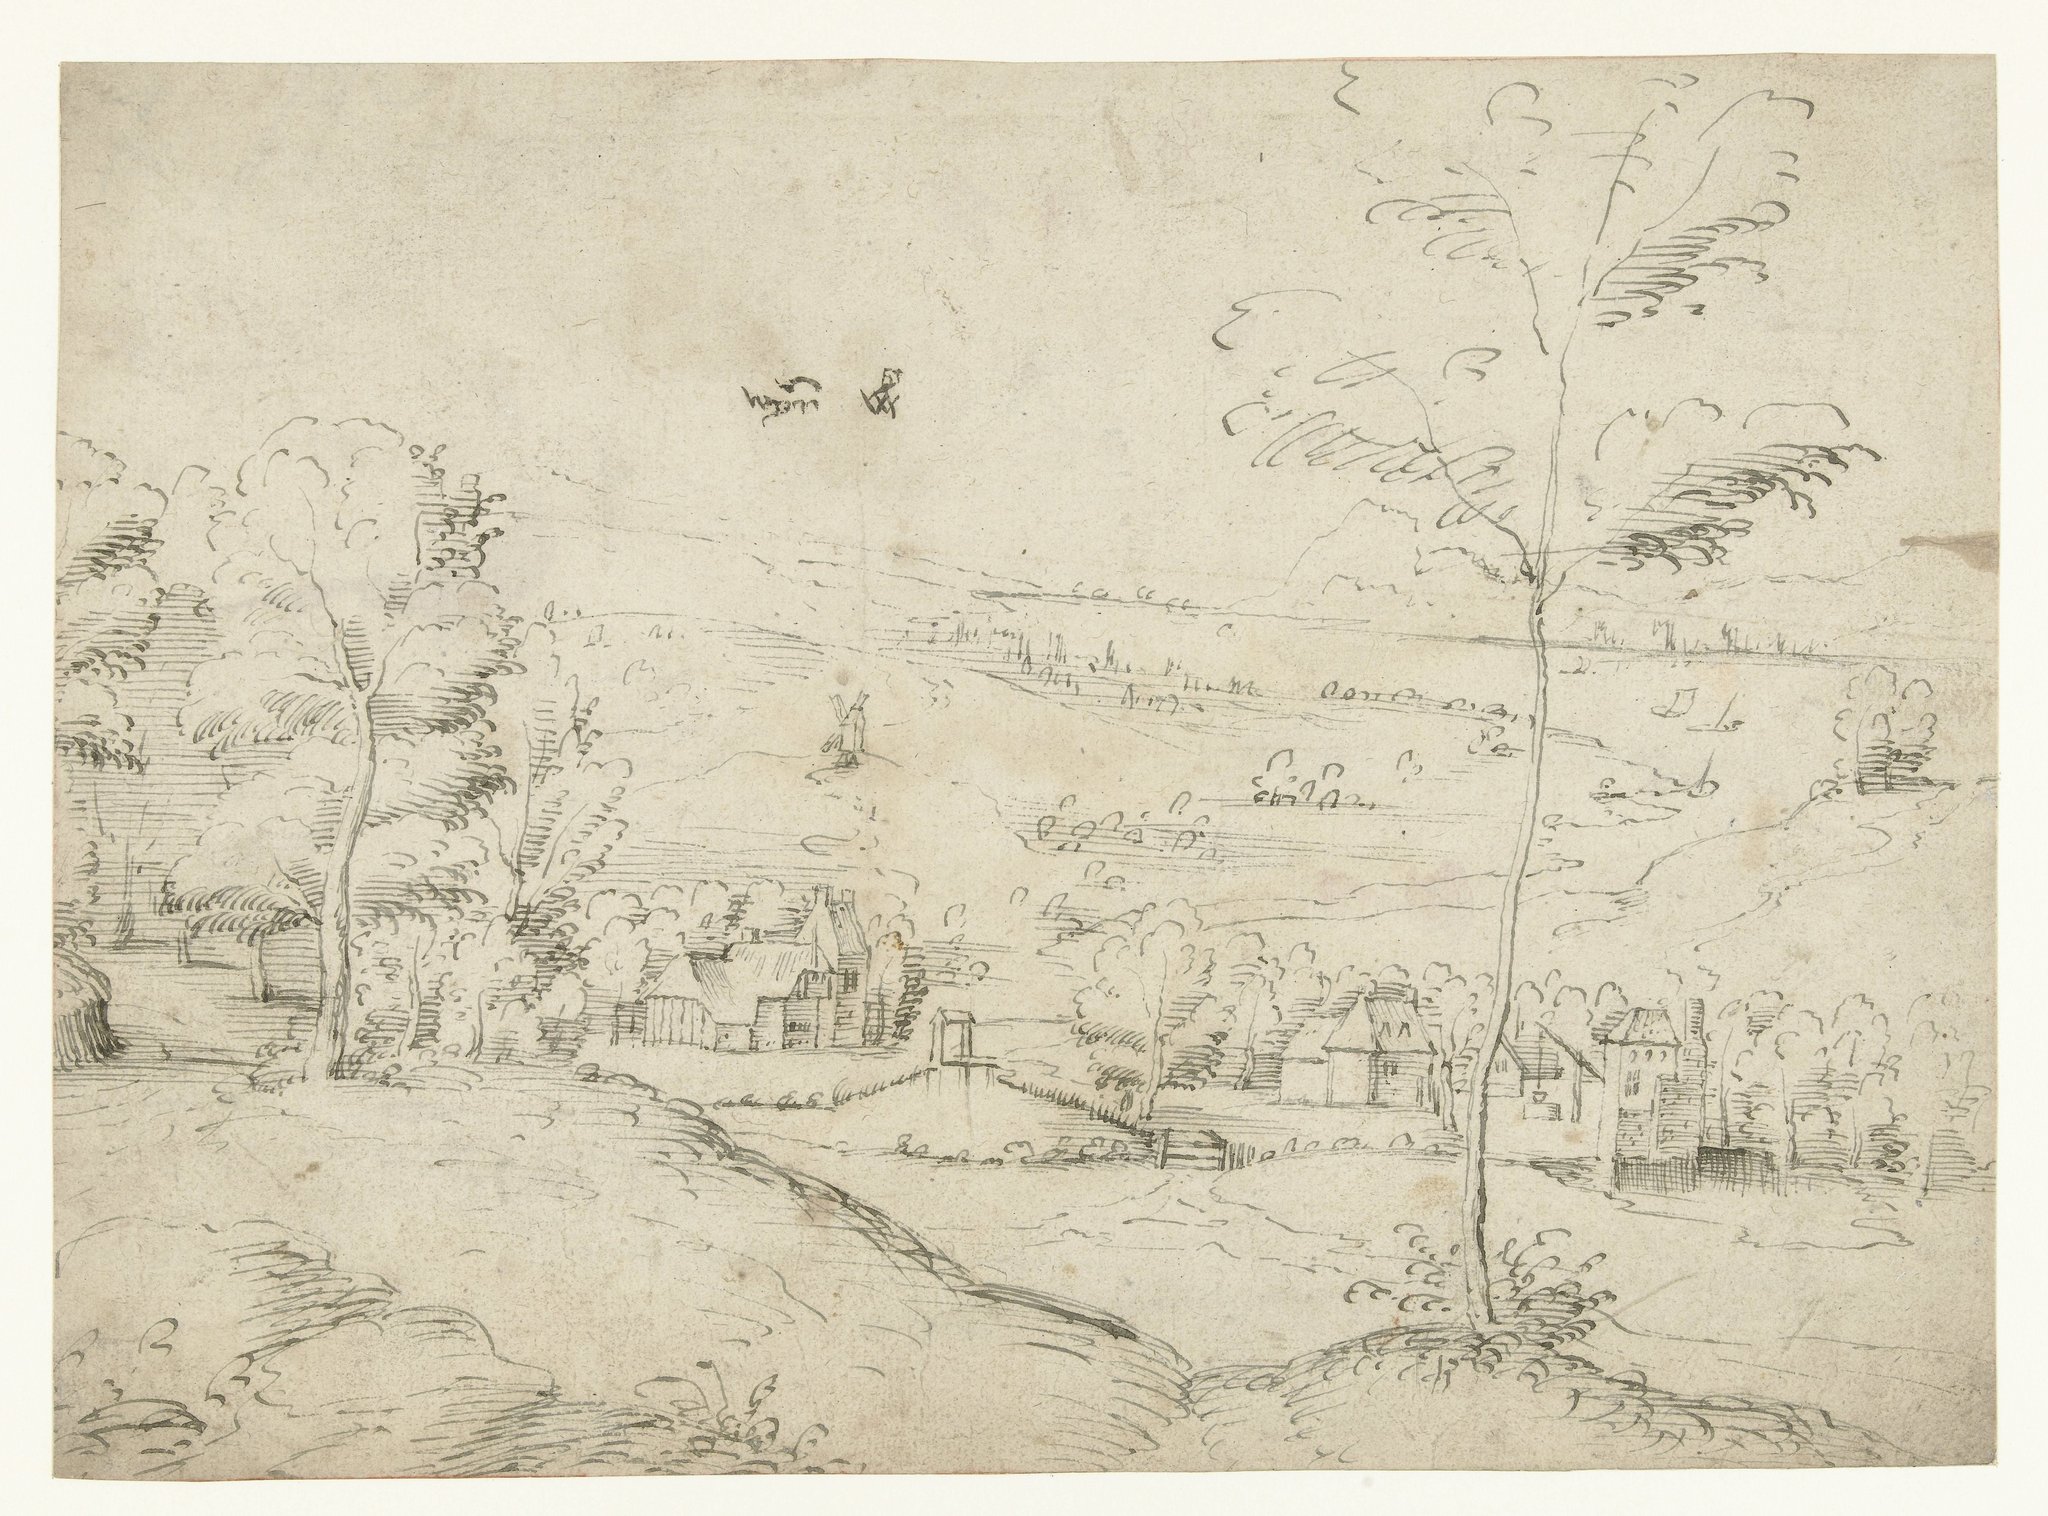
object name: drawing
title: Landschap met boerderijen bij een rivier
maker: joachim patinir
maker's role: draughtsman, painter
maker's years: 1480-1524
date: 1530-1550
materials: ink, paper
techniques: pen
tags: low hill country, river